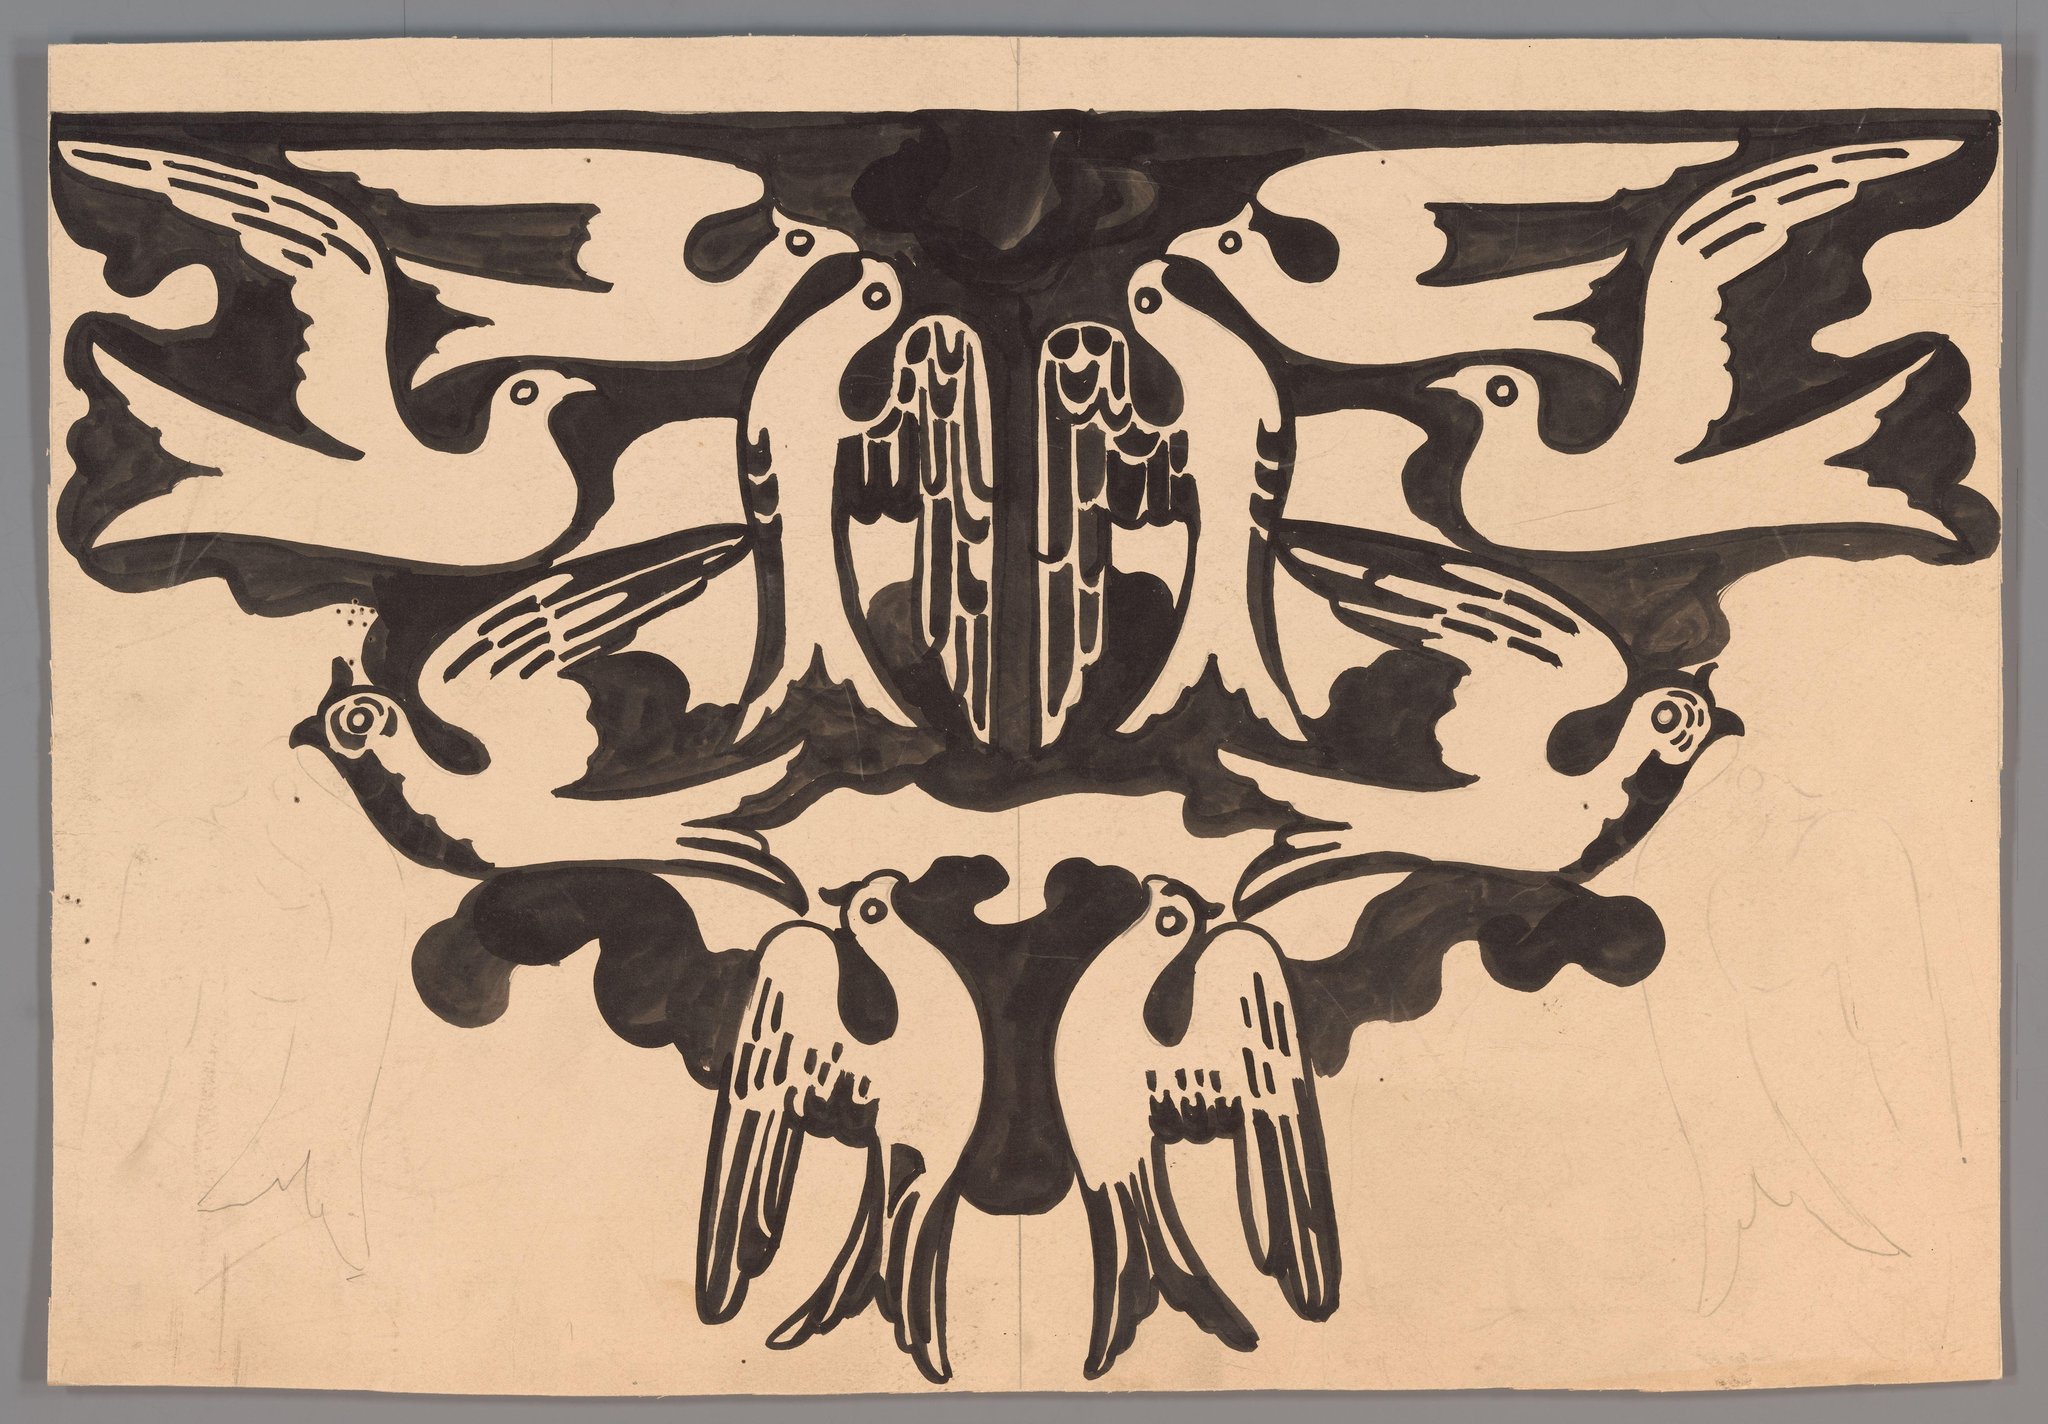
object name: design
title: Ontwerp voor wandtapijt met tien duiven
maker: carel adolph lion cachet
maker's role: draughtsman, print maker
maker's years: 1864-1945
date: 1874-1945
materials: cardboard, pencil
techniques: brush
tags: ornament derived from animal forms - aa - stylized, birds, tapestry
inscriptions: inscription: ‘Vogels bij een fontijn’